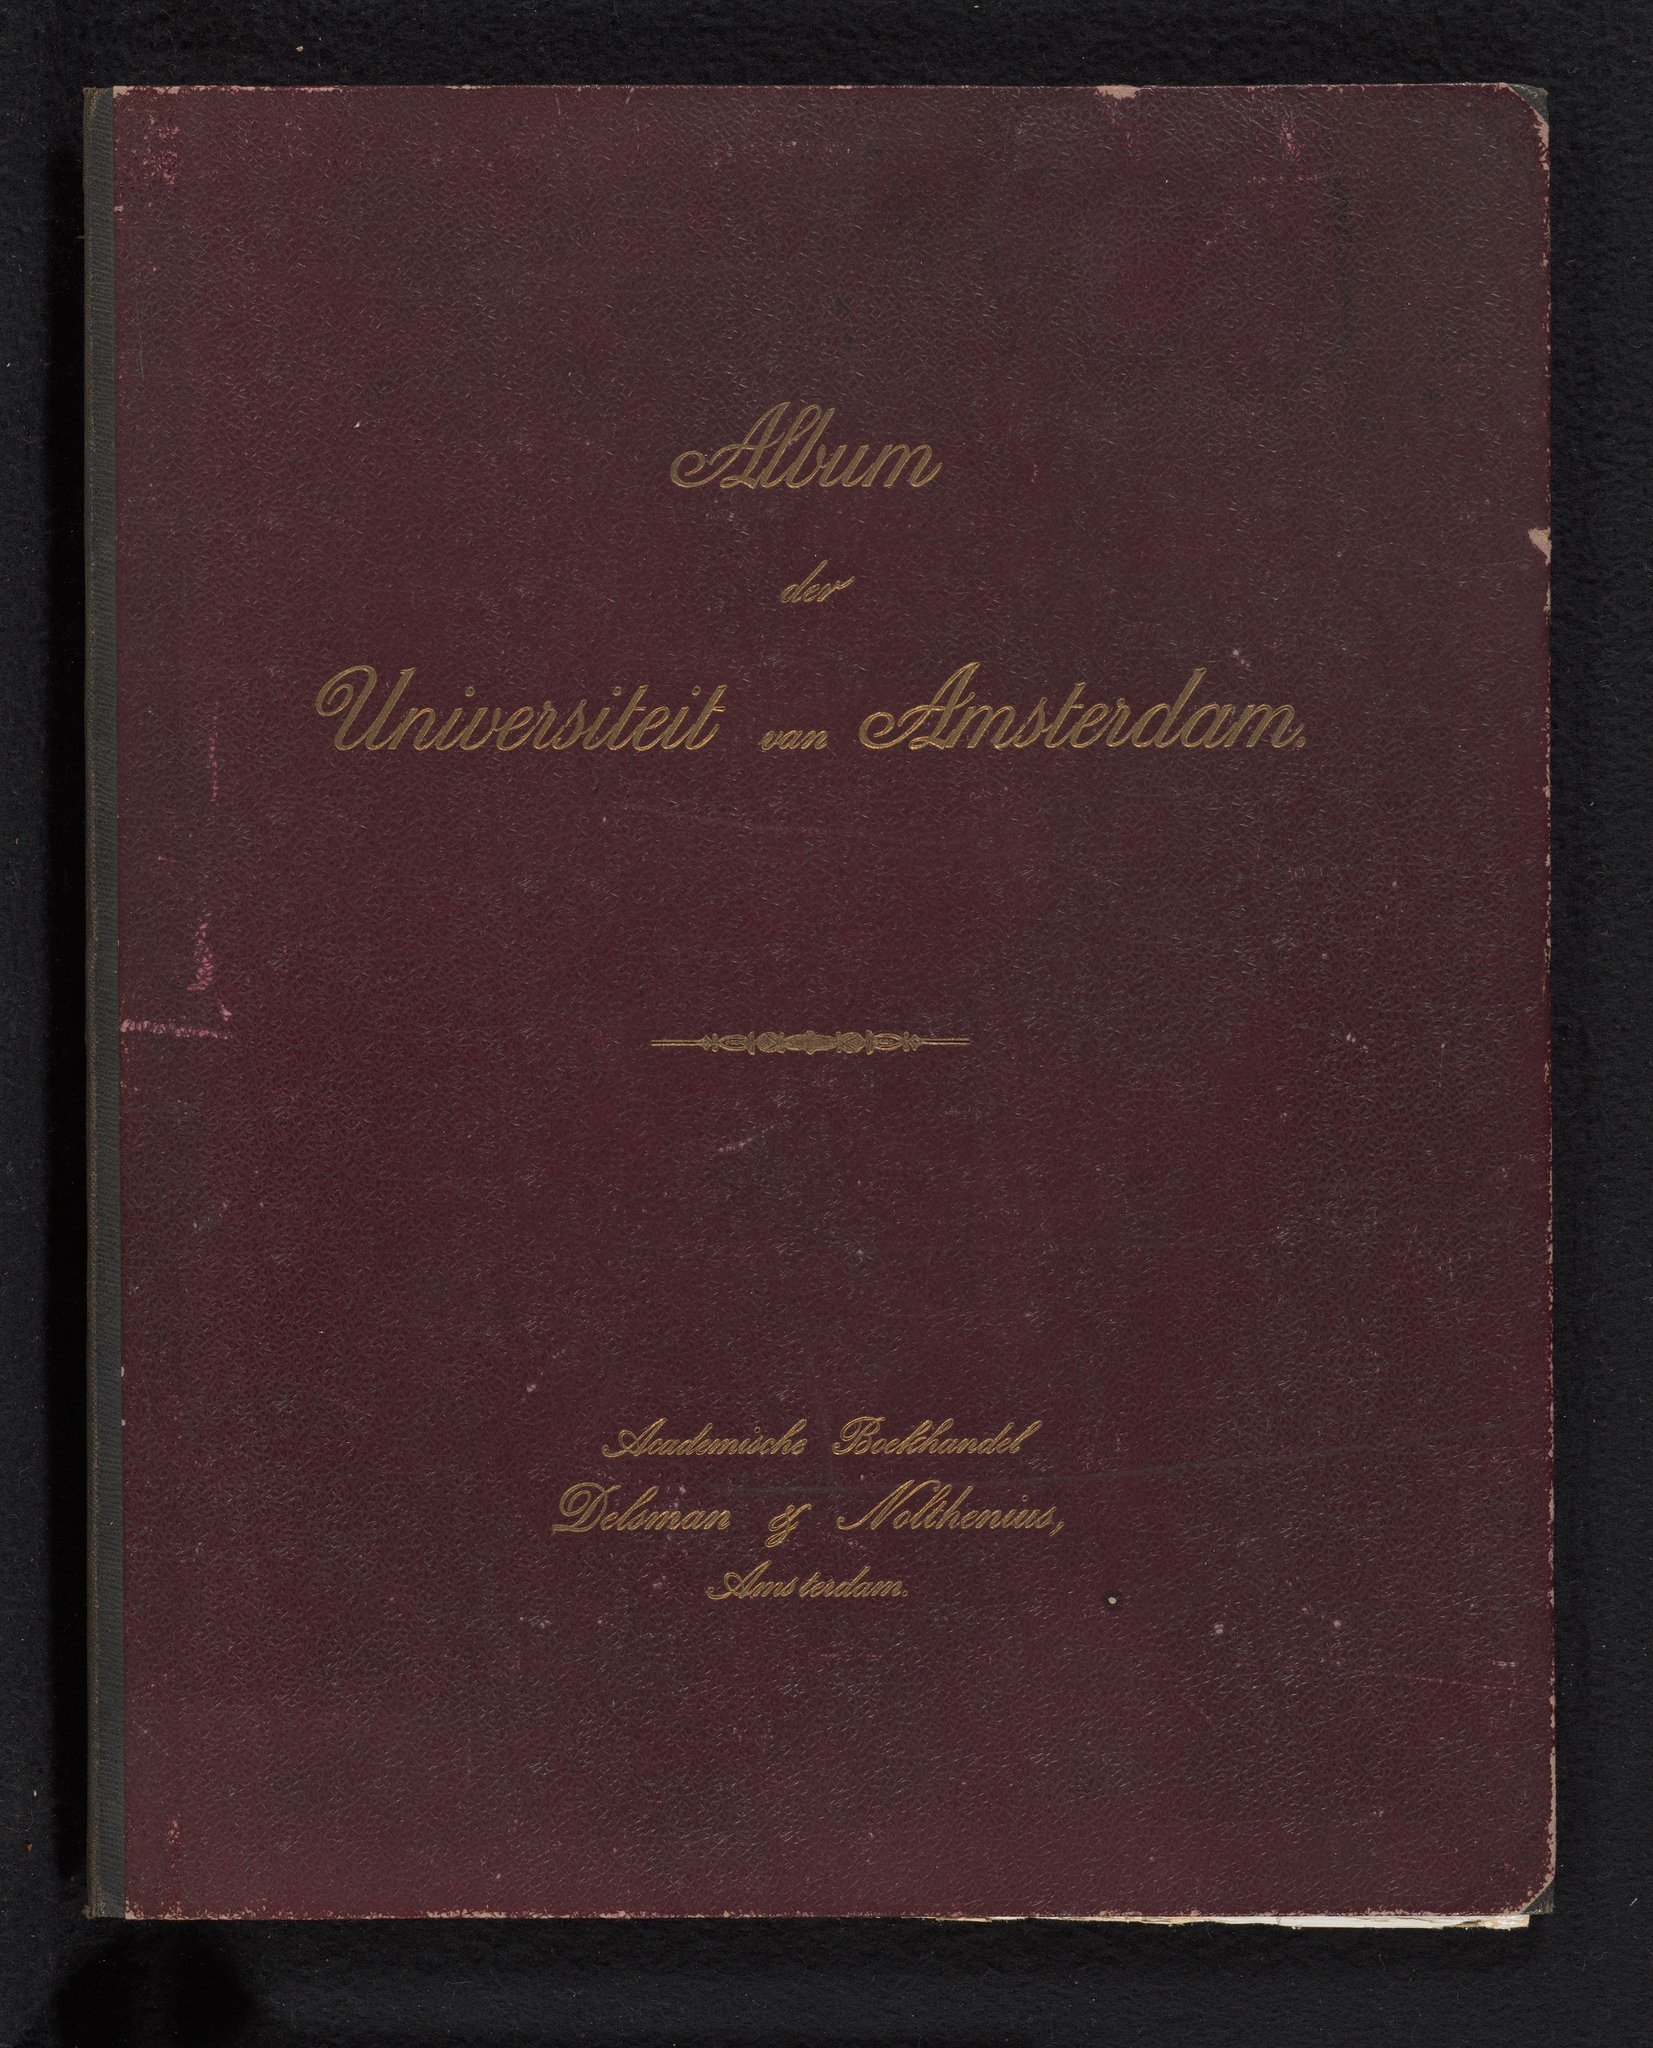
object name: photograph album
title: Omslag voor twaalf bladen met lichtdrukken over de Universiteit van Amsterdam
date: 1902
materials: cardboard, leather, linen, paper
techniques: moire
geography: amsterdam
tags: universiteit van amsterdam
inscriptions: inscription: ‘Anno 1902’, inscription: ‘f 2.75’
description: Omslag met twaalf lichtdrukken op twaalf kartonnen bladen.